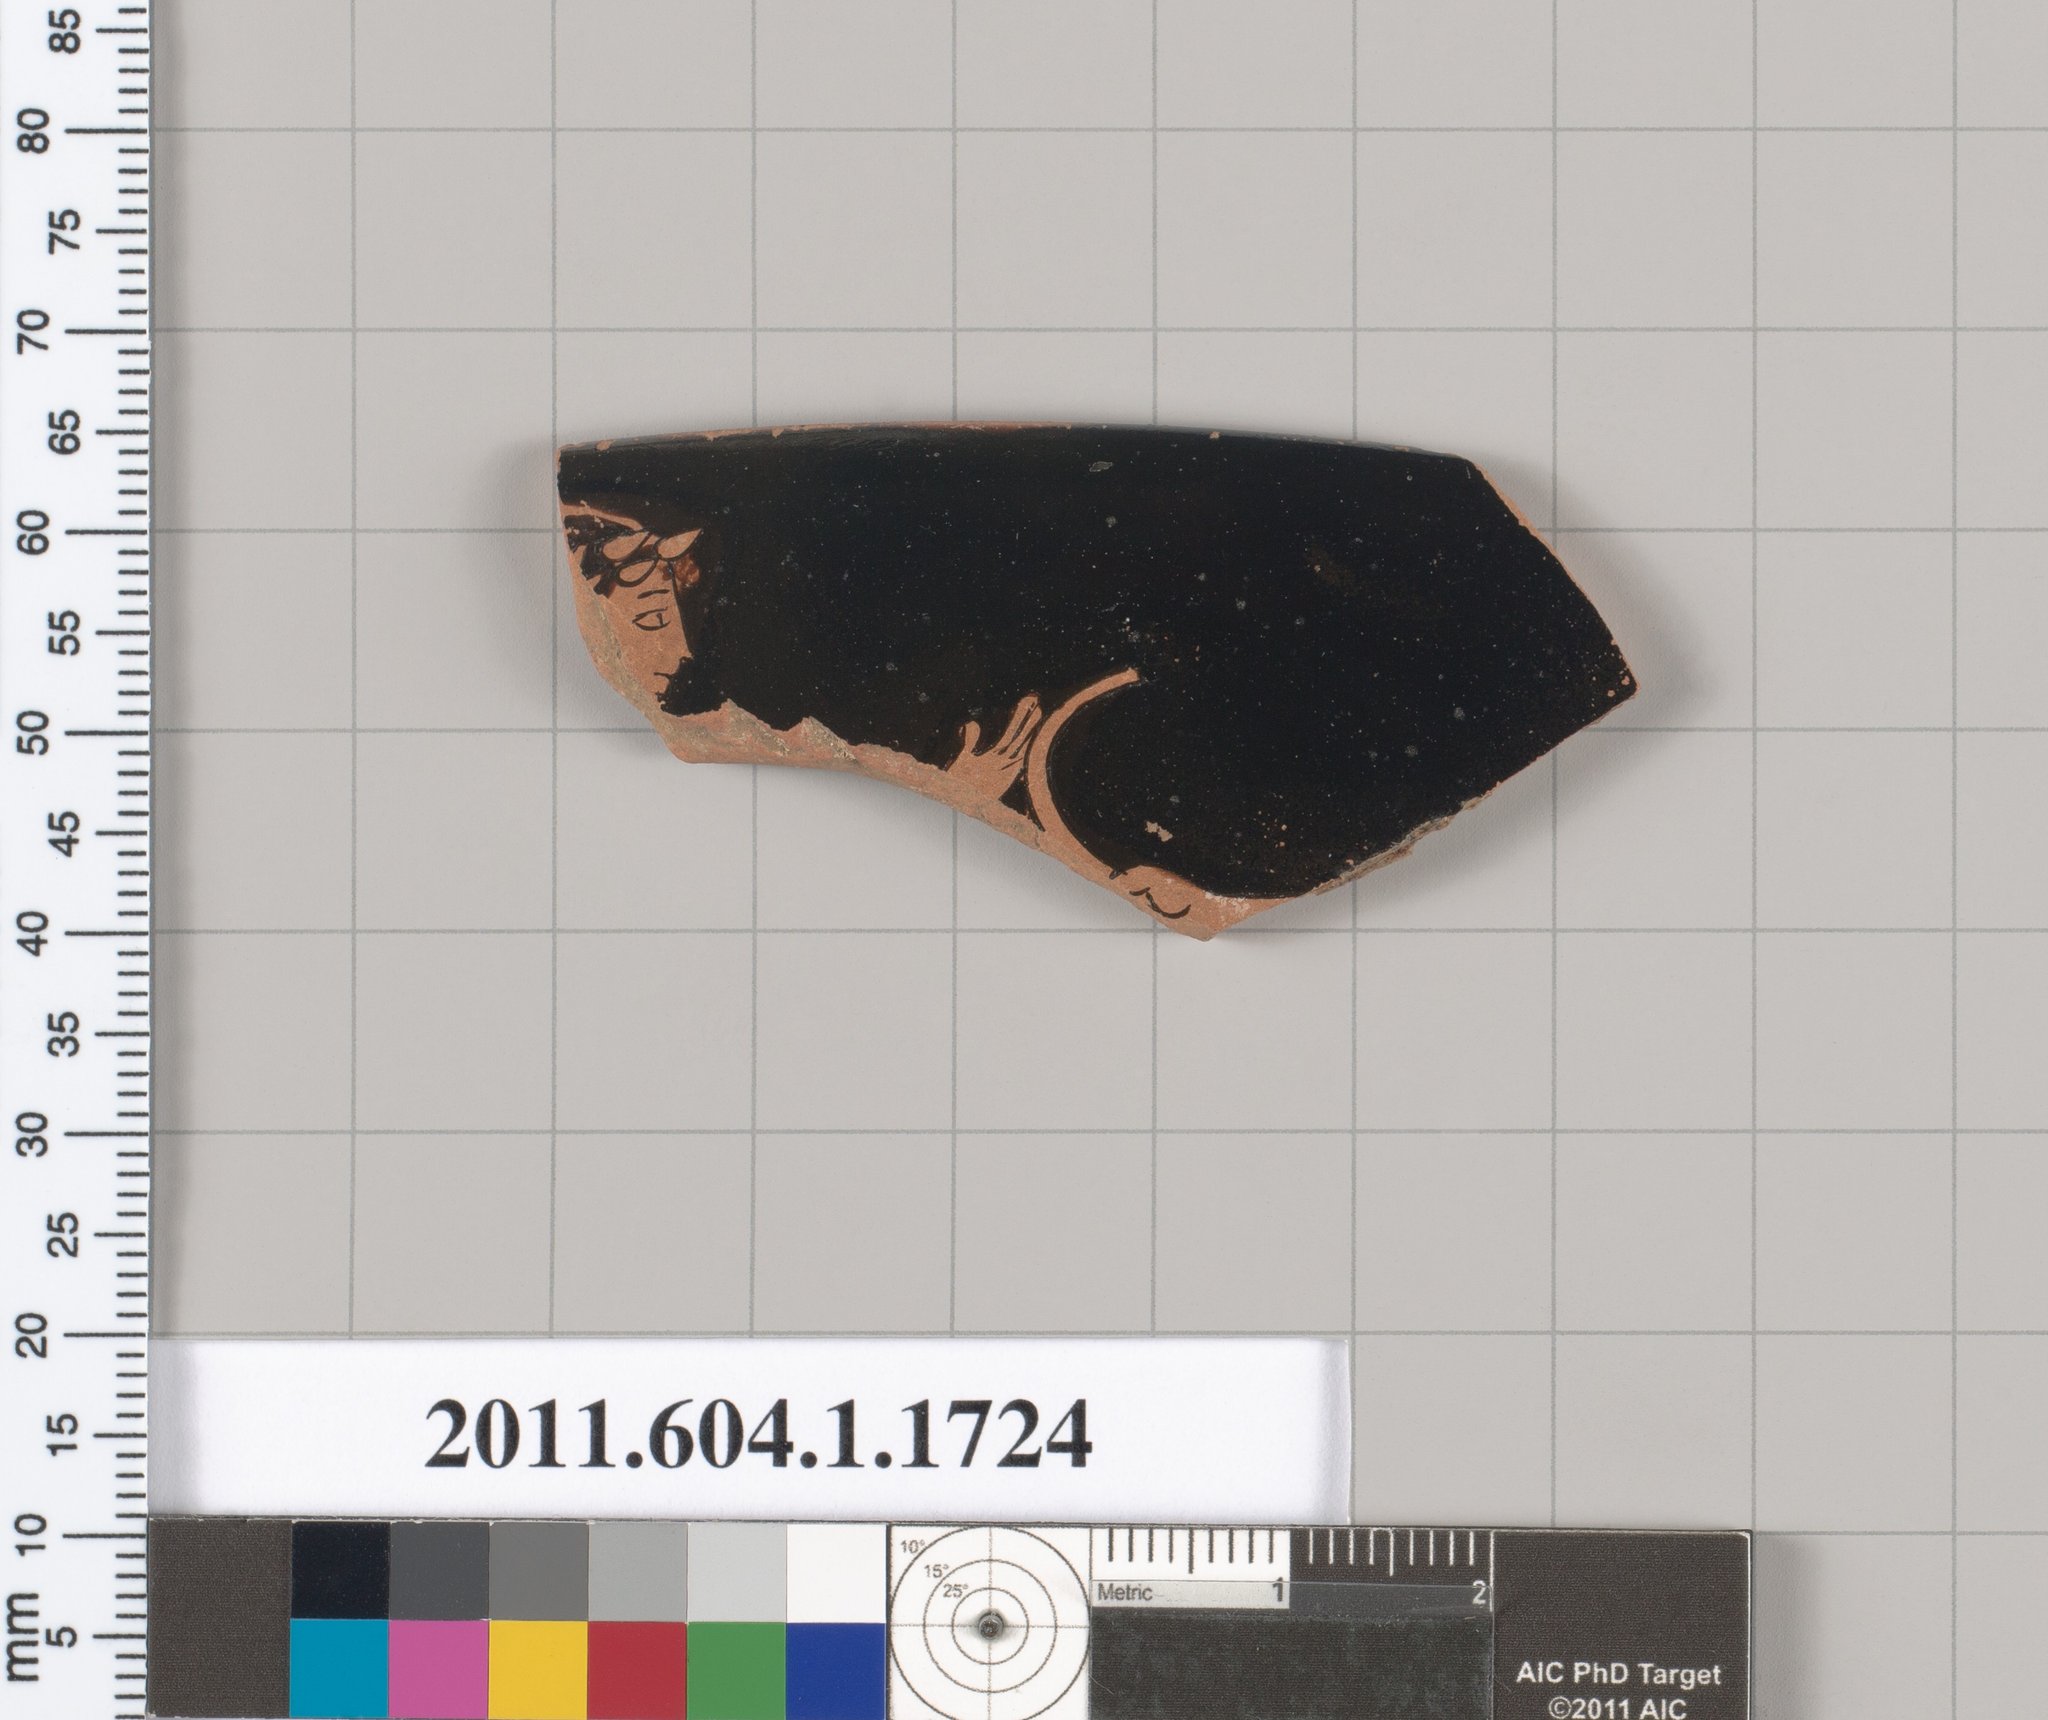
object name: kylix fragment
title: Terracotta rim fragment of a kylix (drinking cup)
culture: greek, attic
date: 475-451 BCE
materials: terracotta